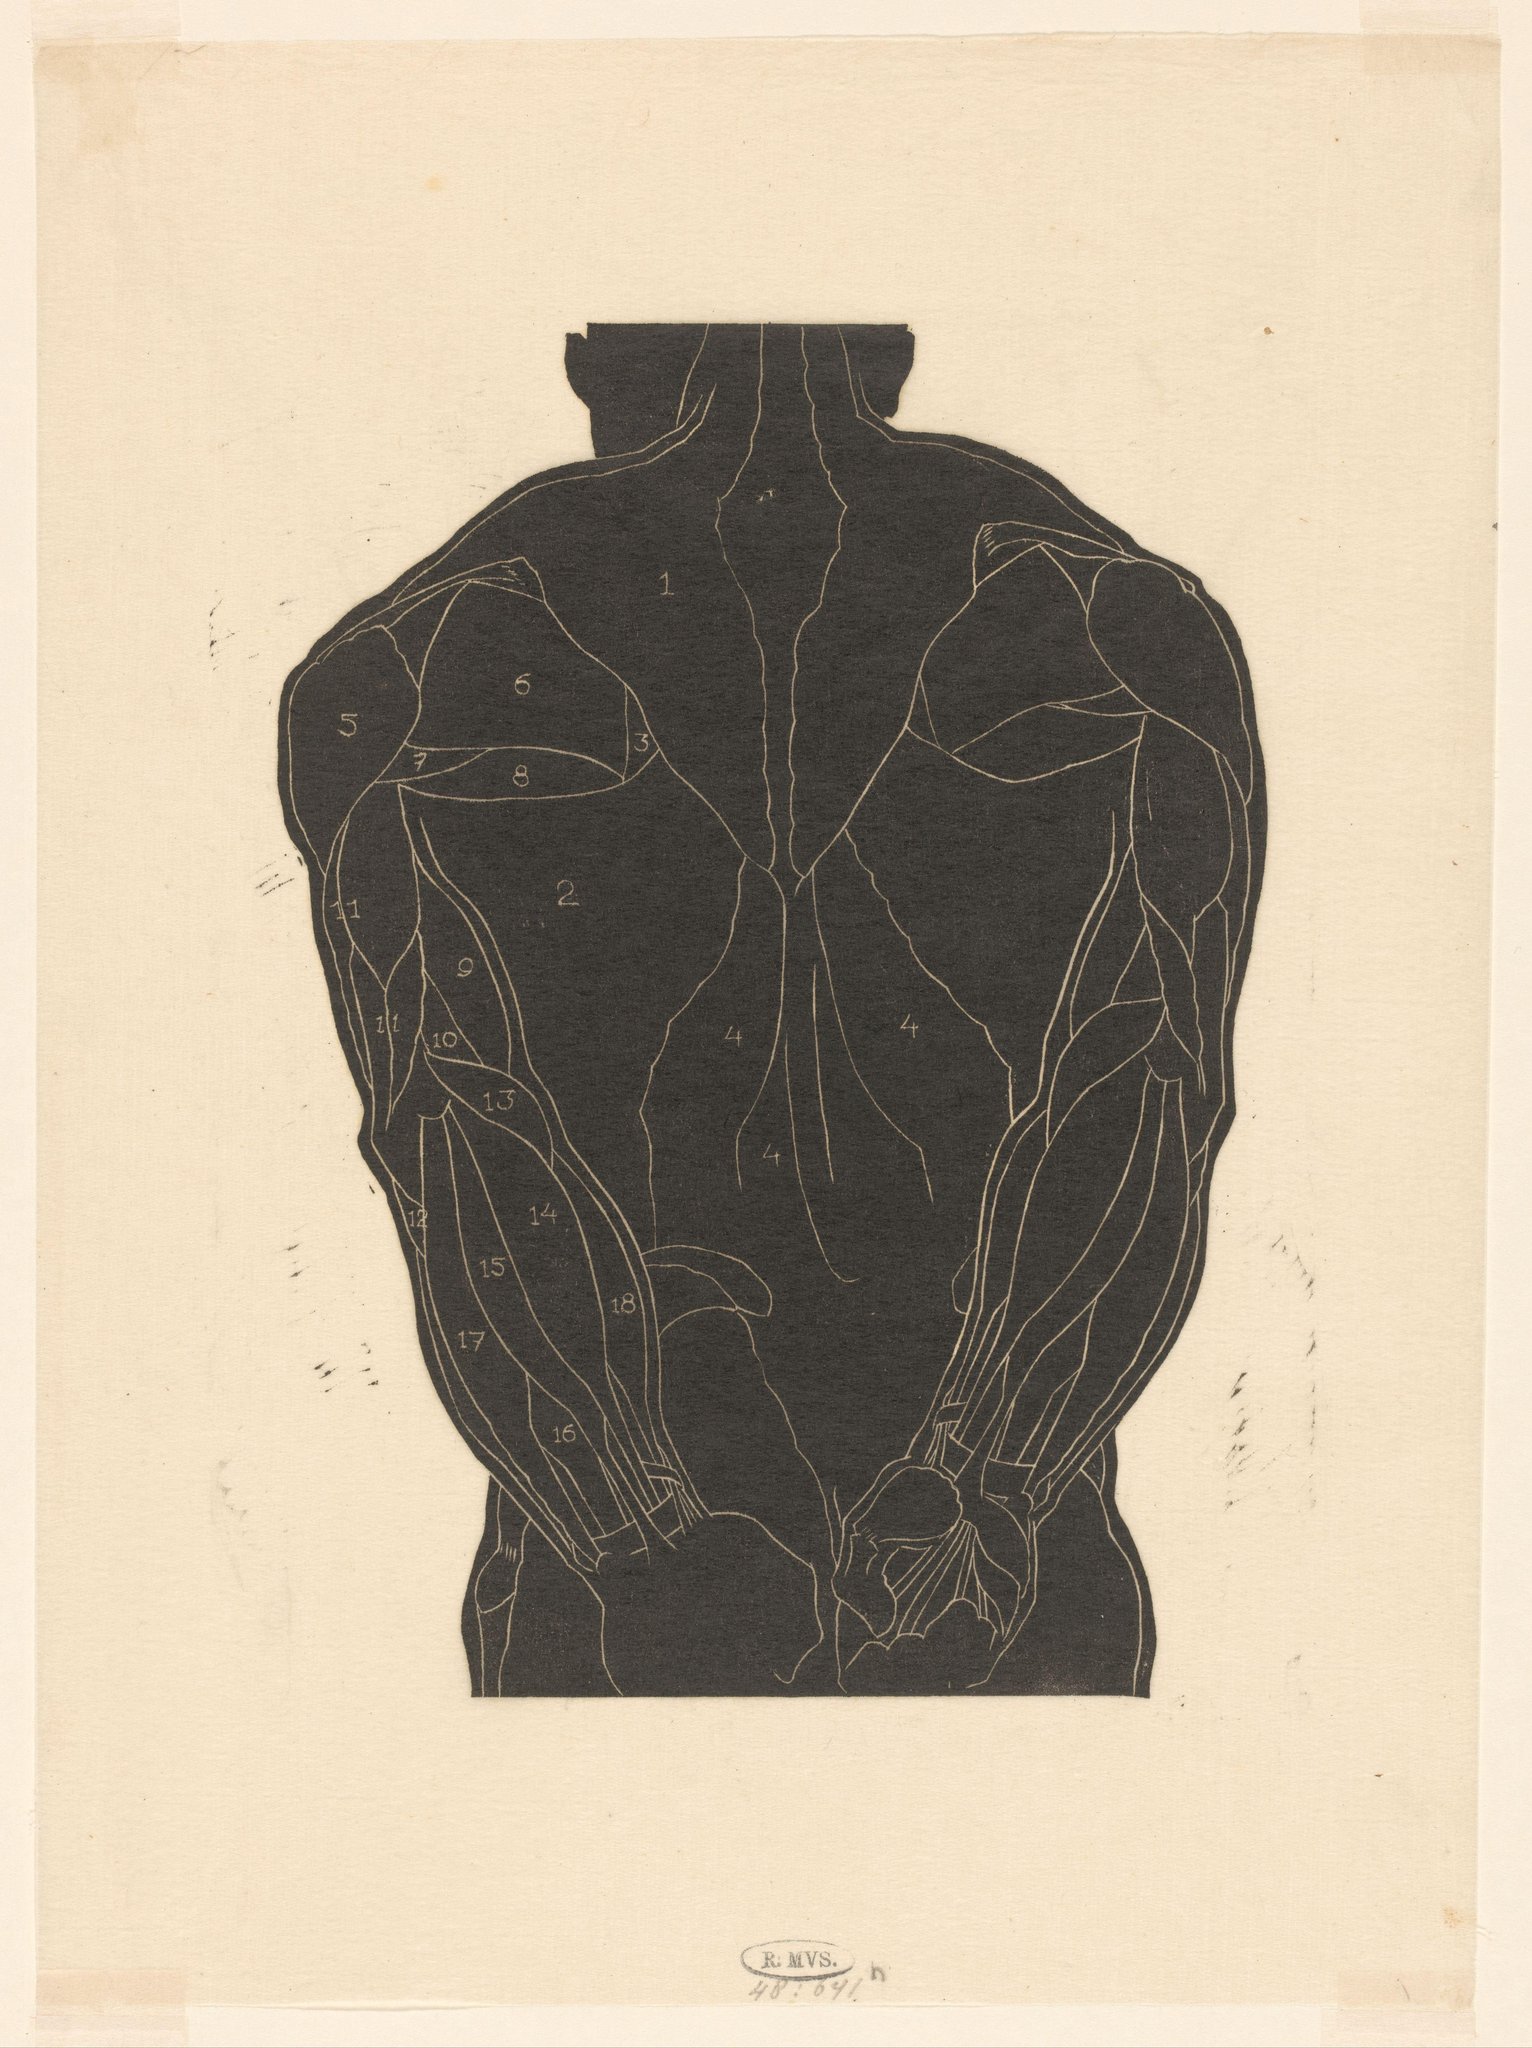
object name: print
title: Anatomische studie van de rugspieren van een man in silhouet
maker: reijer stolk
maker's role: draughtsman, print maker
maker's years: 1896-1945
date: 1906-1945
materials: paper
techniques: woodcut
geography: netherlands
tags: anatomical model of the muscles, muscle-man, 'écorché'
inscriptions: collector's mark: Lugt 2228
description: Prent gebruikt voor: Stolk, Reyer. Anatomische studies in houtsneden. Amsterdam: G.W. Breughel, 1946, plaat 3.